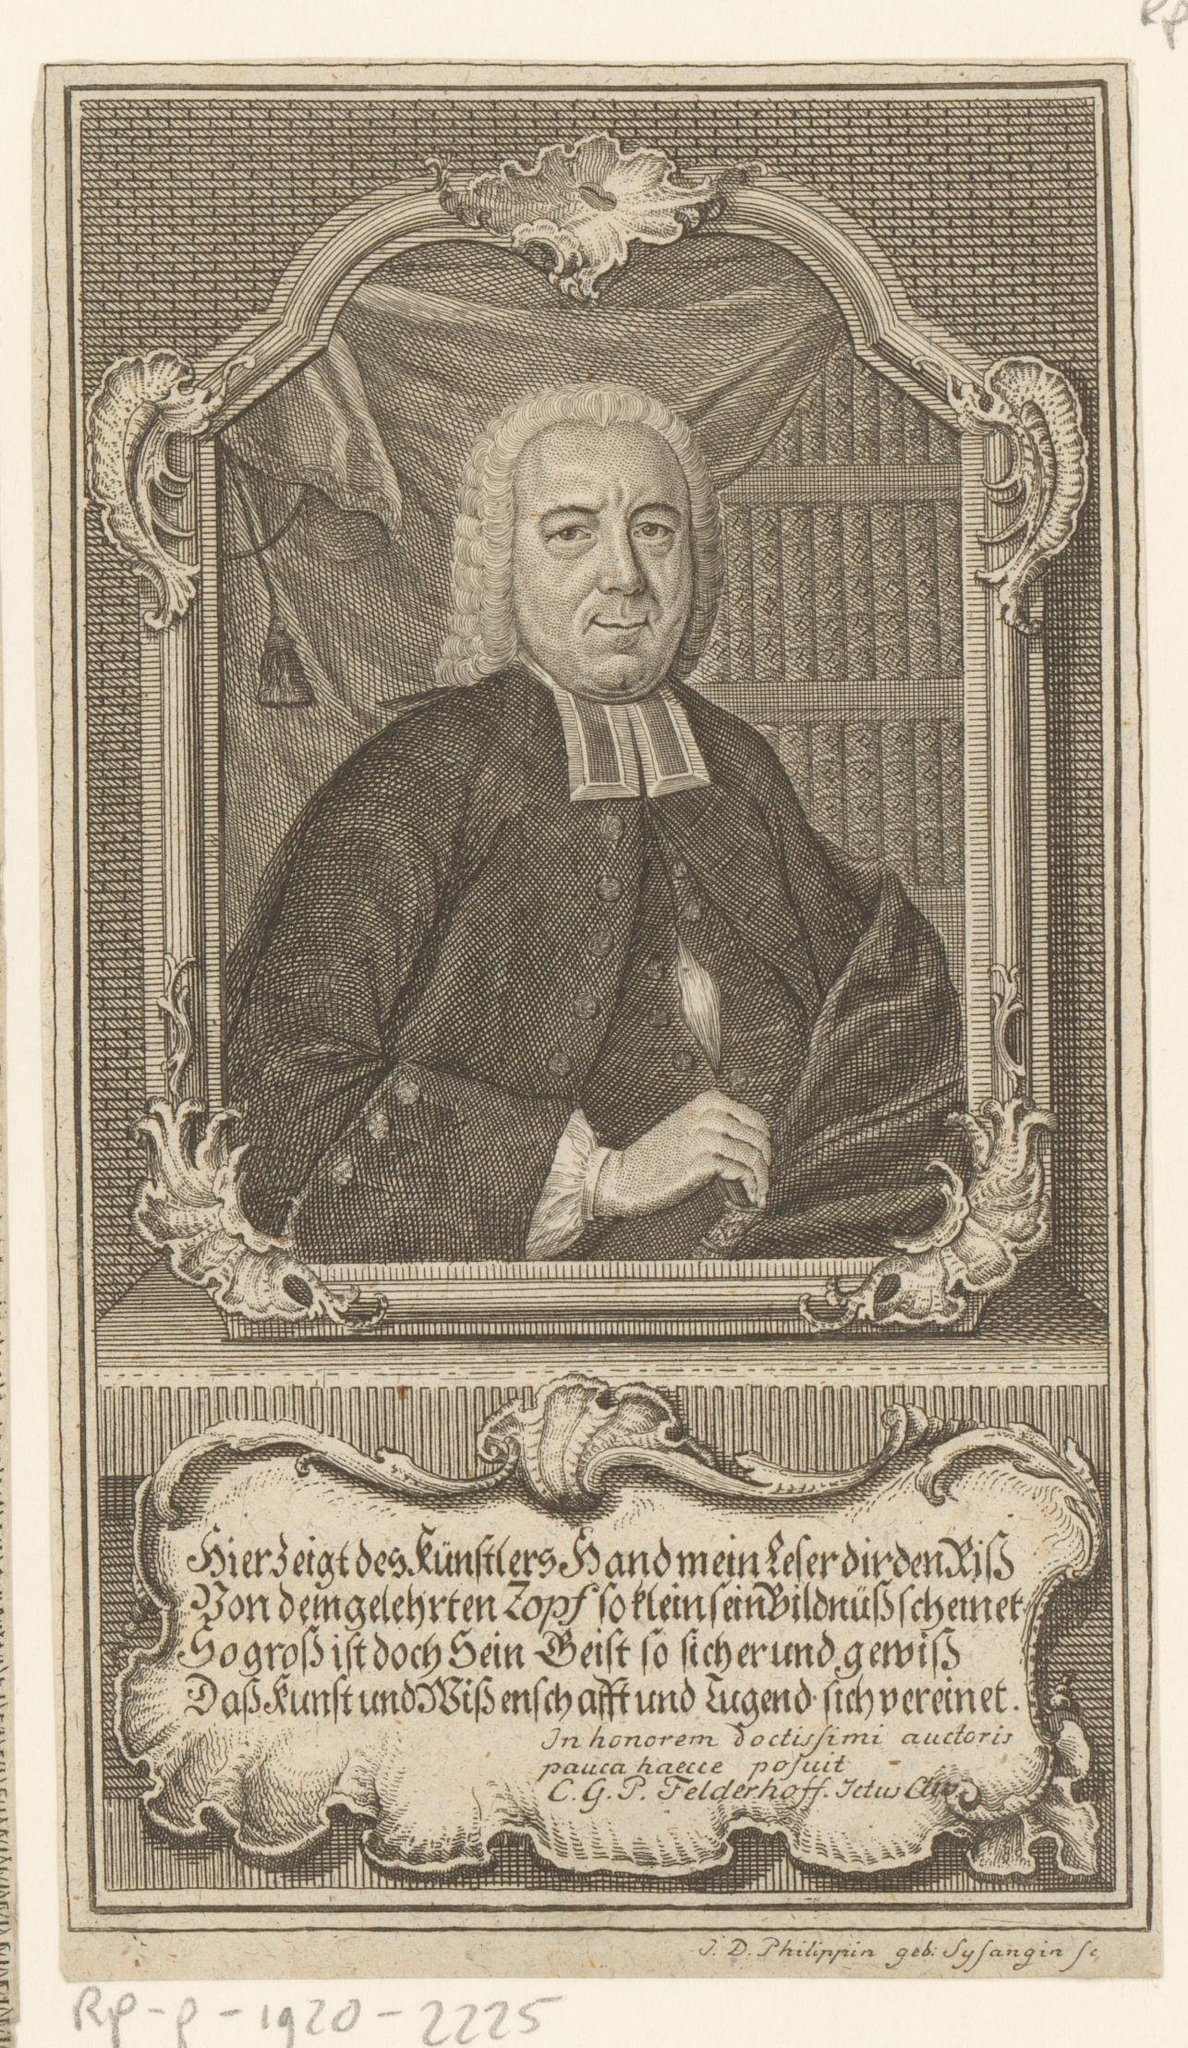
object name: print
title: Portret van Zopf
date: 1739-1791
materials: paper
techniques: engraving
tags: historical persons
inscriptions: collector's mark: Lugt 2228